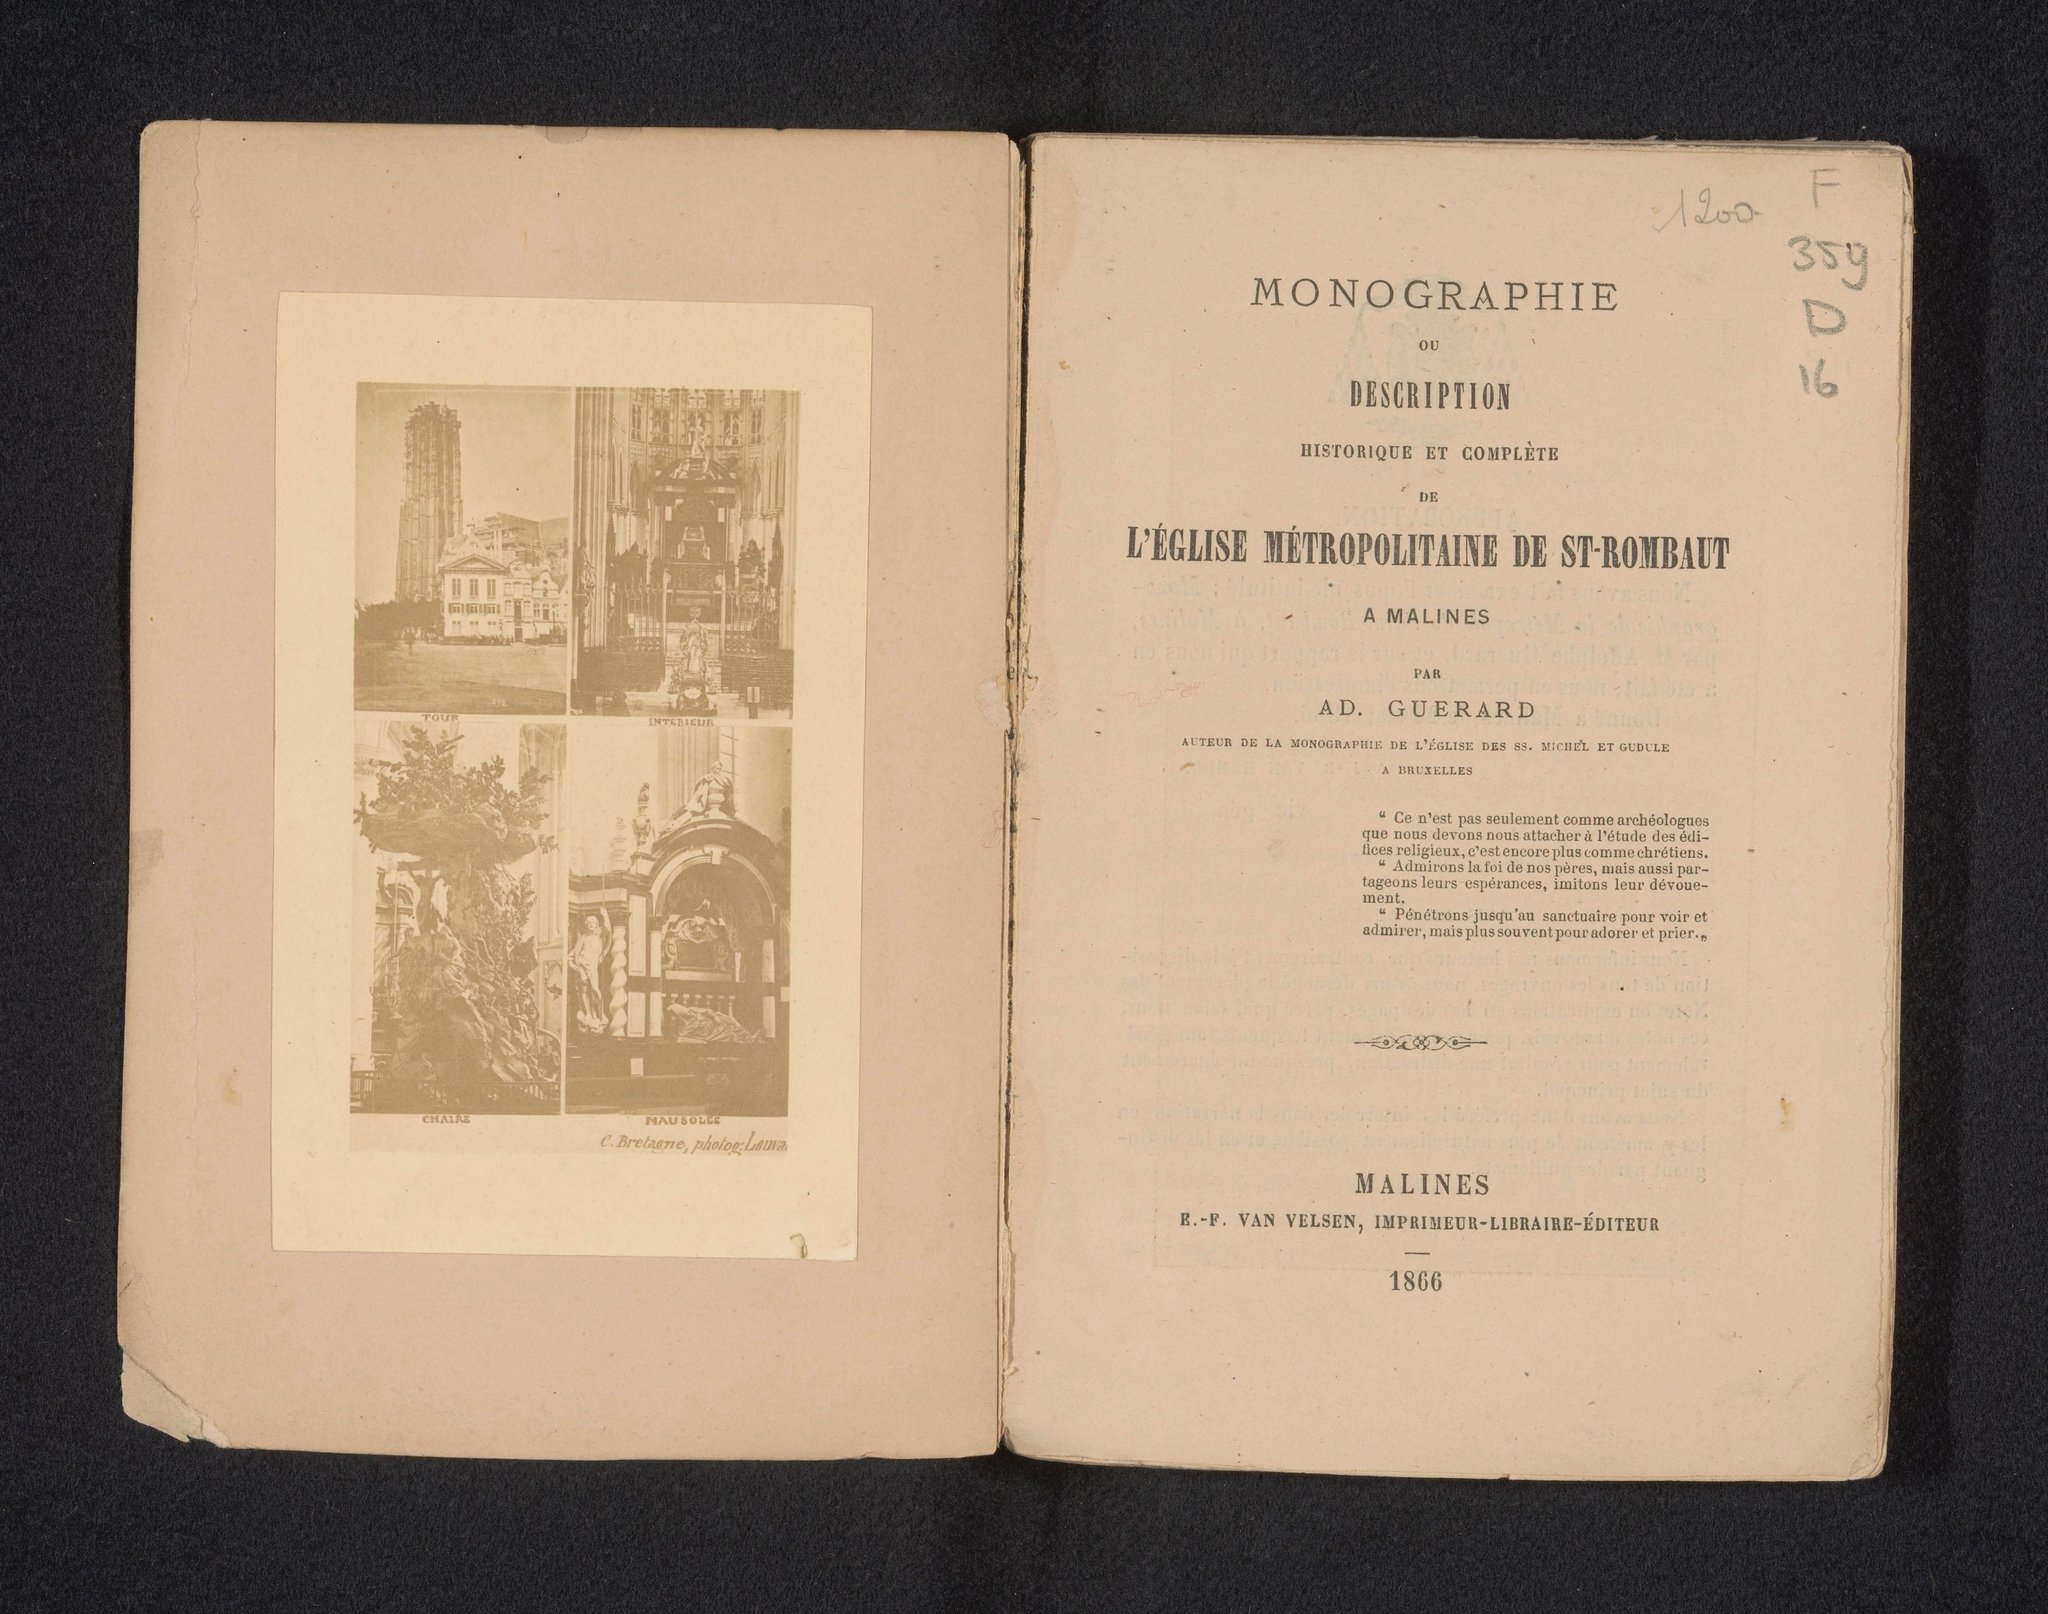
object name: book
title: Monographie ou description historique et complète de l'eglise métropolitaine de St-Rombaut à Malines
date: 1866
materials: linen, paper, photographic support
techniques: albumen print, printing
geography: mechelen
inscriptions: date: ‘Nov 1991’